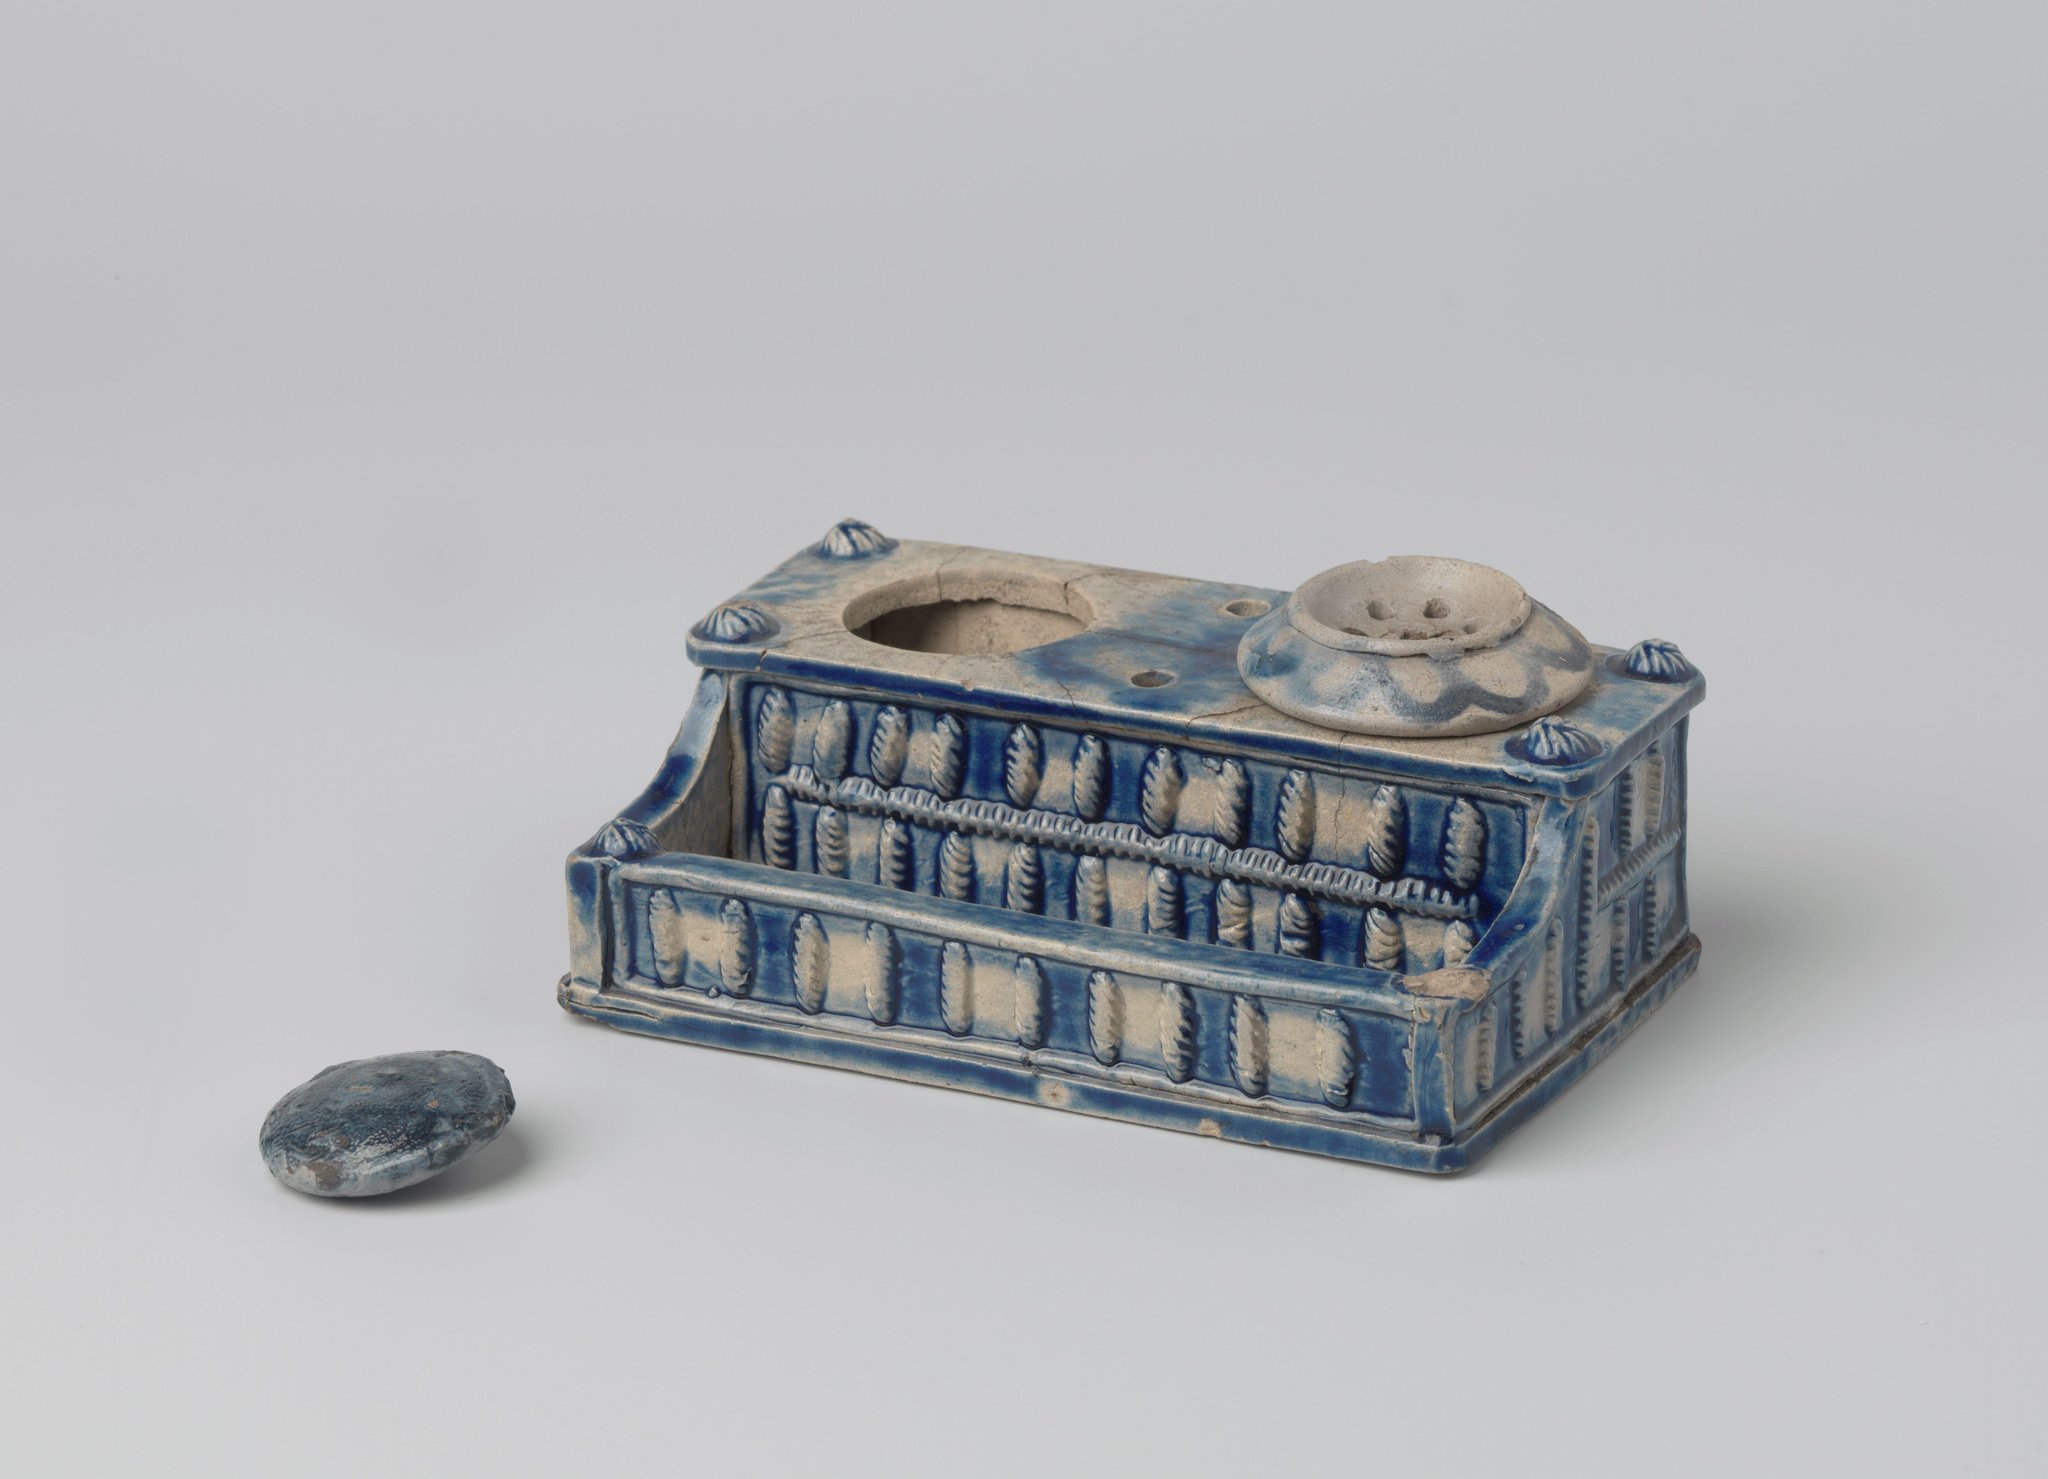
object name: sander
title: Sand shaker with pierced top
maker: Anonymous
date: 1750-1799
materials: cobalt, glaze, stoneware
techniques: embroidery, firing, turning, vitrification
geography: westerwald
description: Zandstrooier van steengoed met een cilindrisch lichaam, uitlopende rand om in de houder te plaatsen en opengewerkte bovenzijde. De rand met een bloembladpatroon in kobaltblauw. Westerwald.